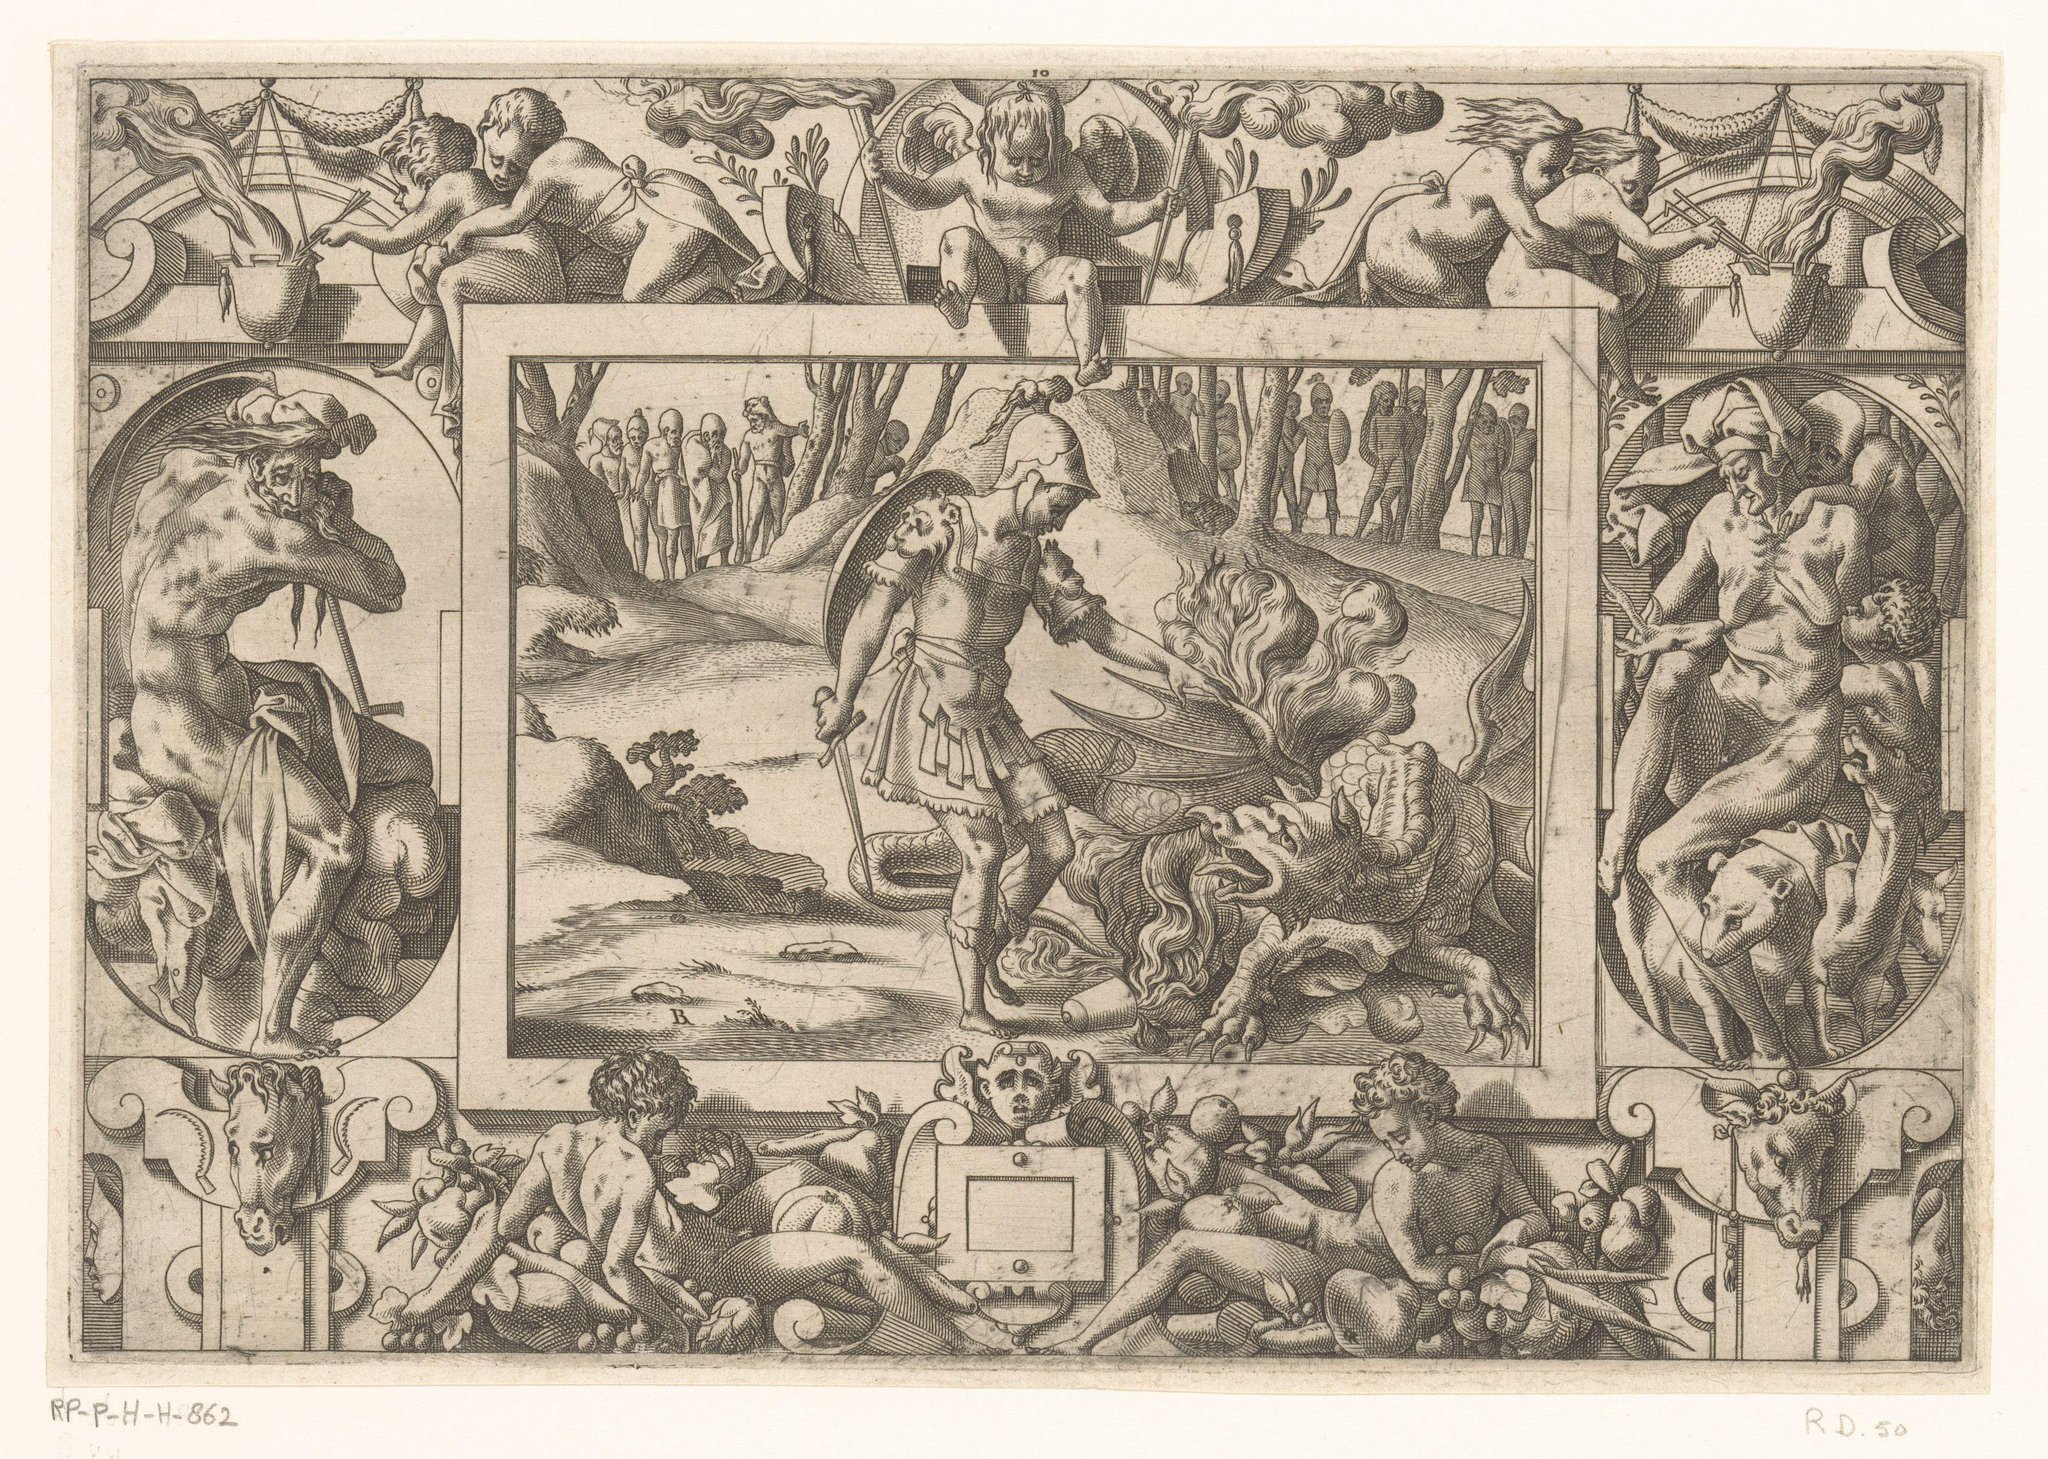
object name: print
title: Jason verslaat de draak die het gulden vlies bewaakt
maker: rené boyvin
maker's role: print maker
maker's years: 1525-1598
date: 1563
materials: paper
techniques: engraving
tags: fight with the dragon; jason sprinkles a drug in its eyes, possibly assisted by medea, the story of the argonauts: the quest for the golden fleece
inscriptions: collector's mark: Lugt 11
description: Maakt deel uit van een serie van 26 prenten met scènes uit het verhaal van Jason en het gulden vlies, uitgegeven in 1563 te Parijs.